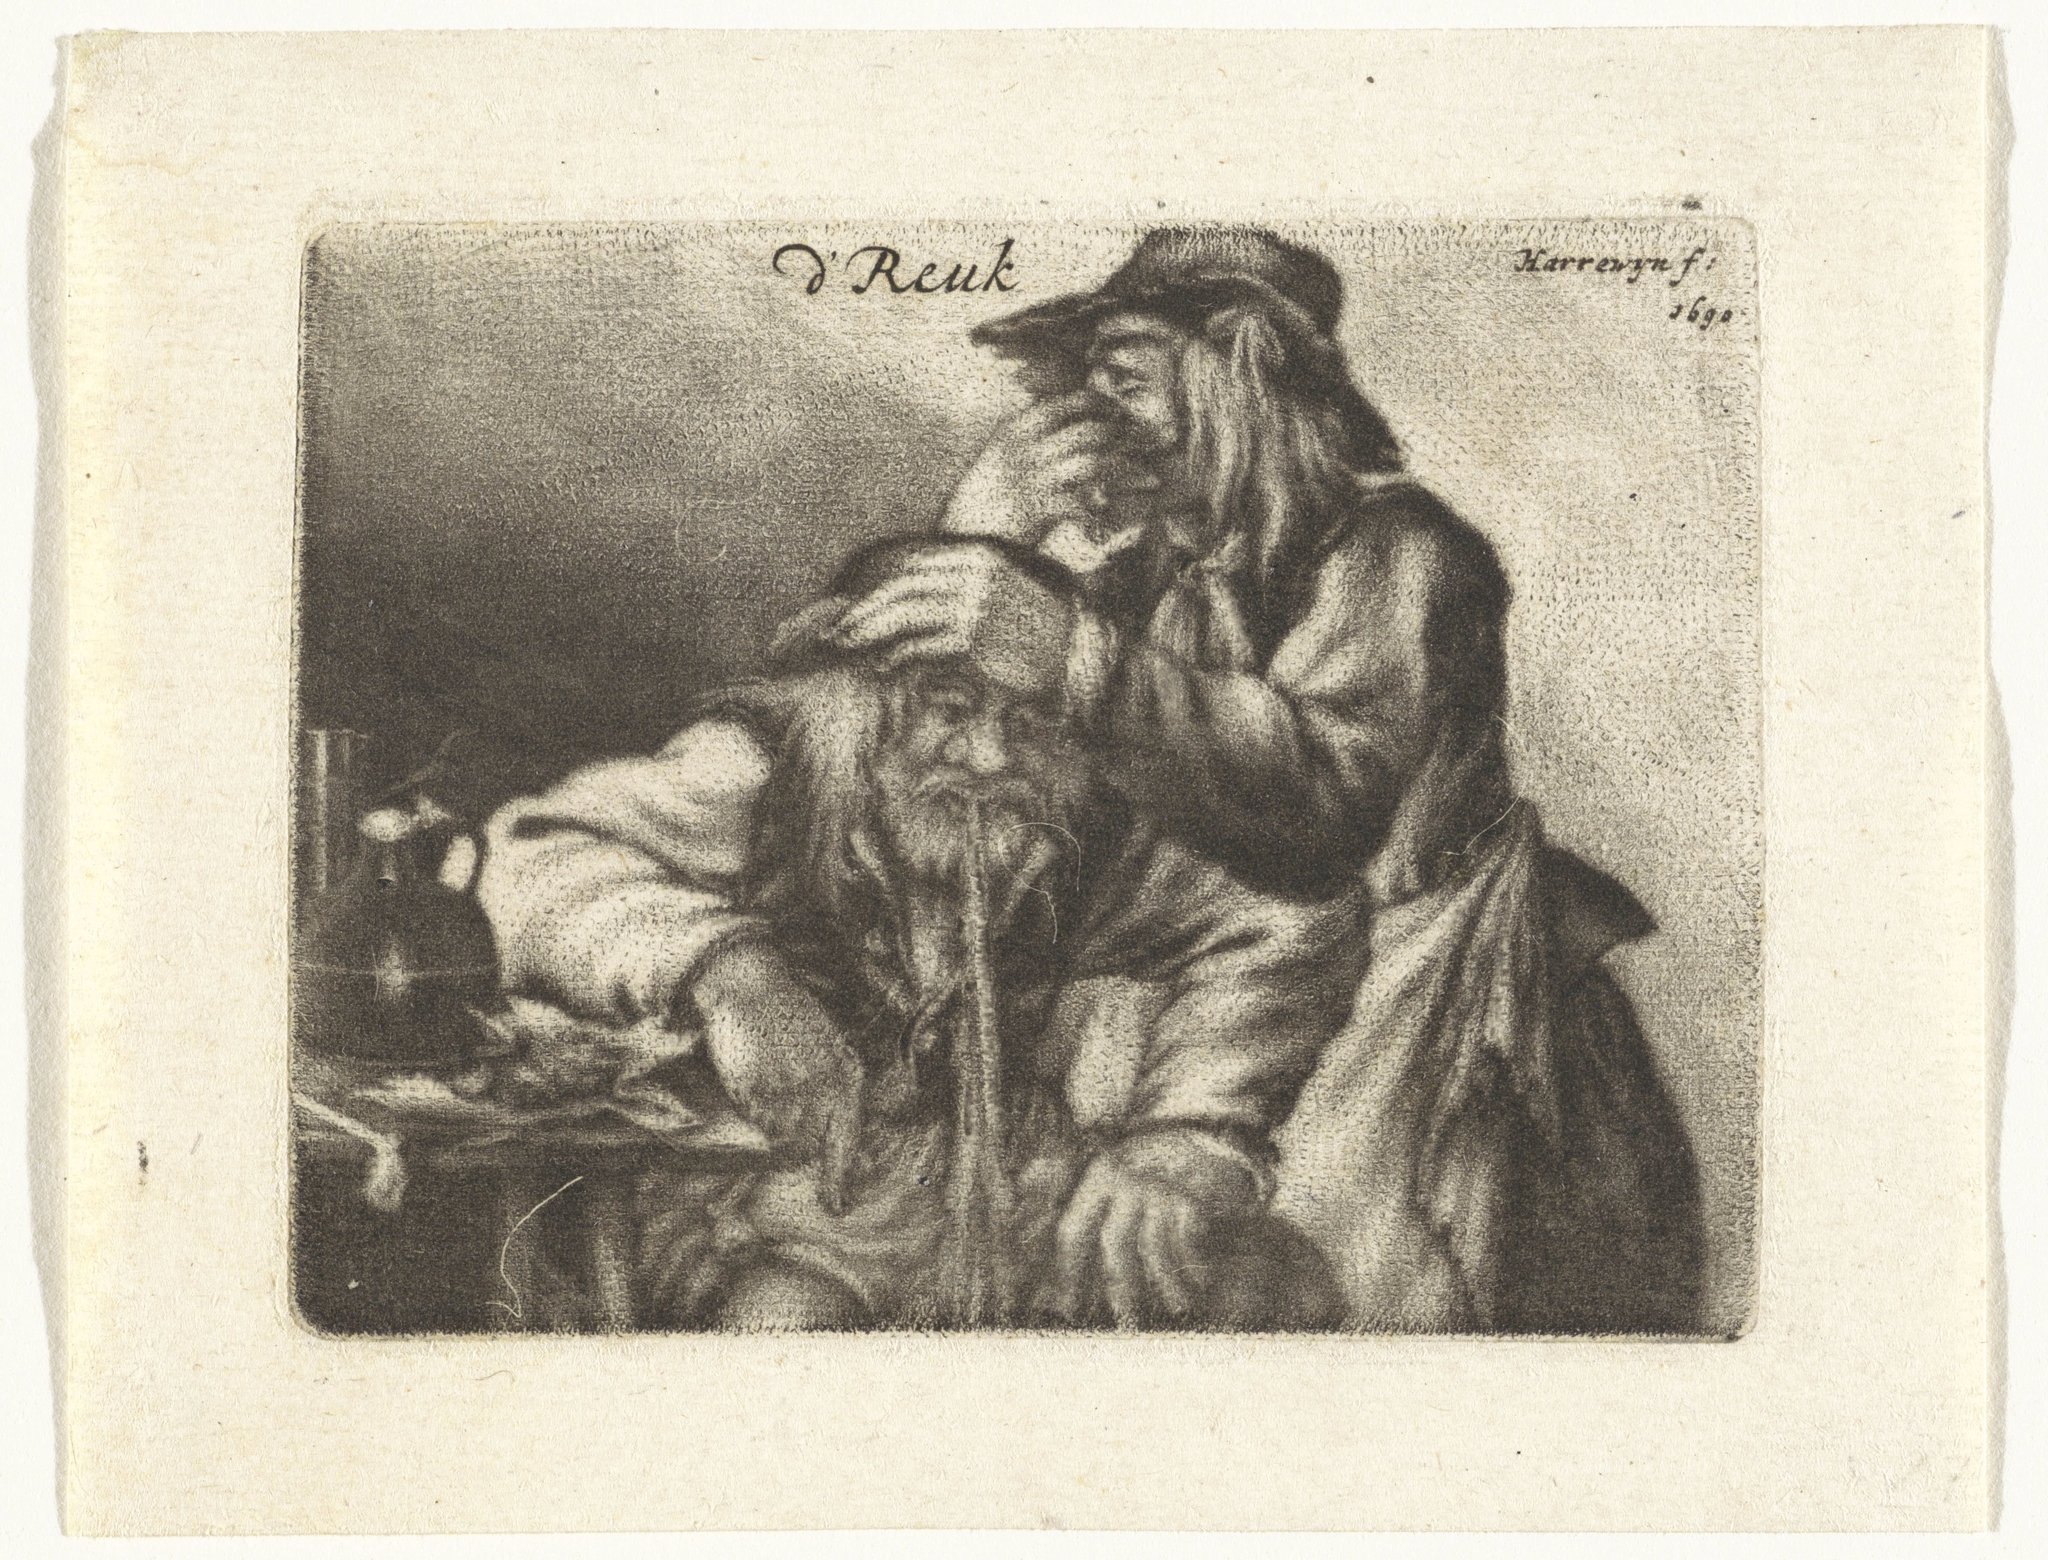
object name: print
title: d'Reuk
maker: jacobus harrewijn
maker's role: print maker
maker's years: 1660-1740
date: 1690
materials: paper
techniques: engraving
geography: southern netherlands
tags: vomiting, smell, smelling (one of the five senses), holding one's nose closed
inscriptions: collector's mark: Lugt 2228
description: De Reuk. Een man geeft over terwijl een tweede man de hand op zijn hoofd heeft gelegd en zijn eigen neus dicht knijpt. Op de tafel naast hen een pijp en een wijnkruik. De prent maakt deel uit van een serie van vijf prenten met de vijf zintuigen.